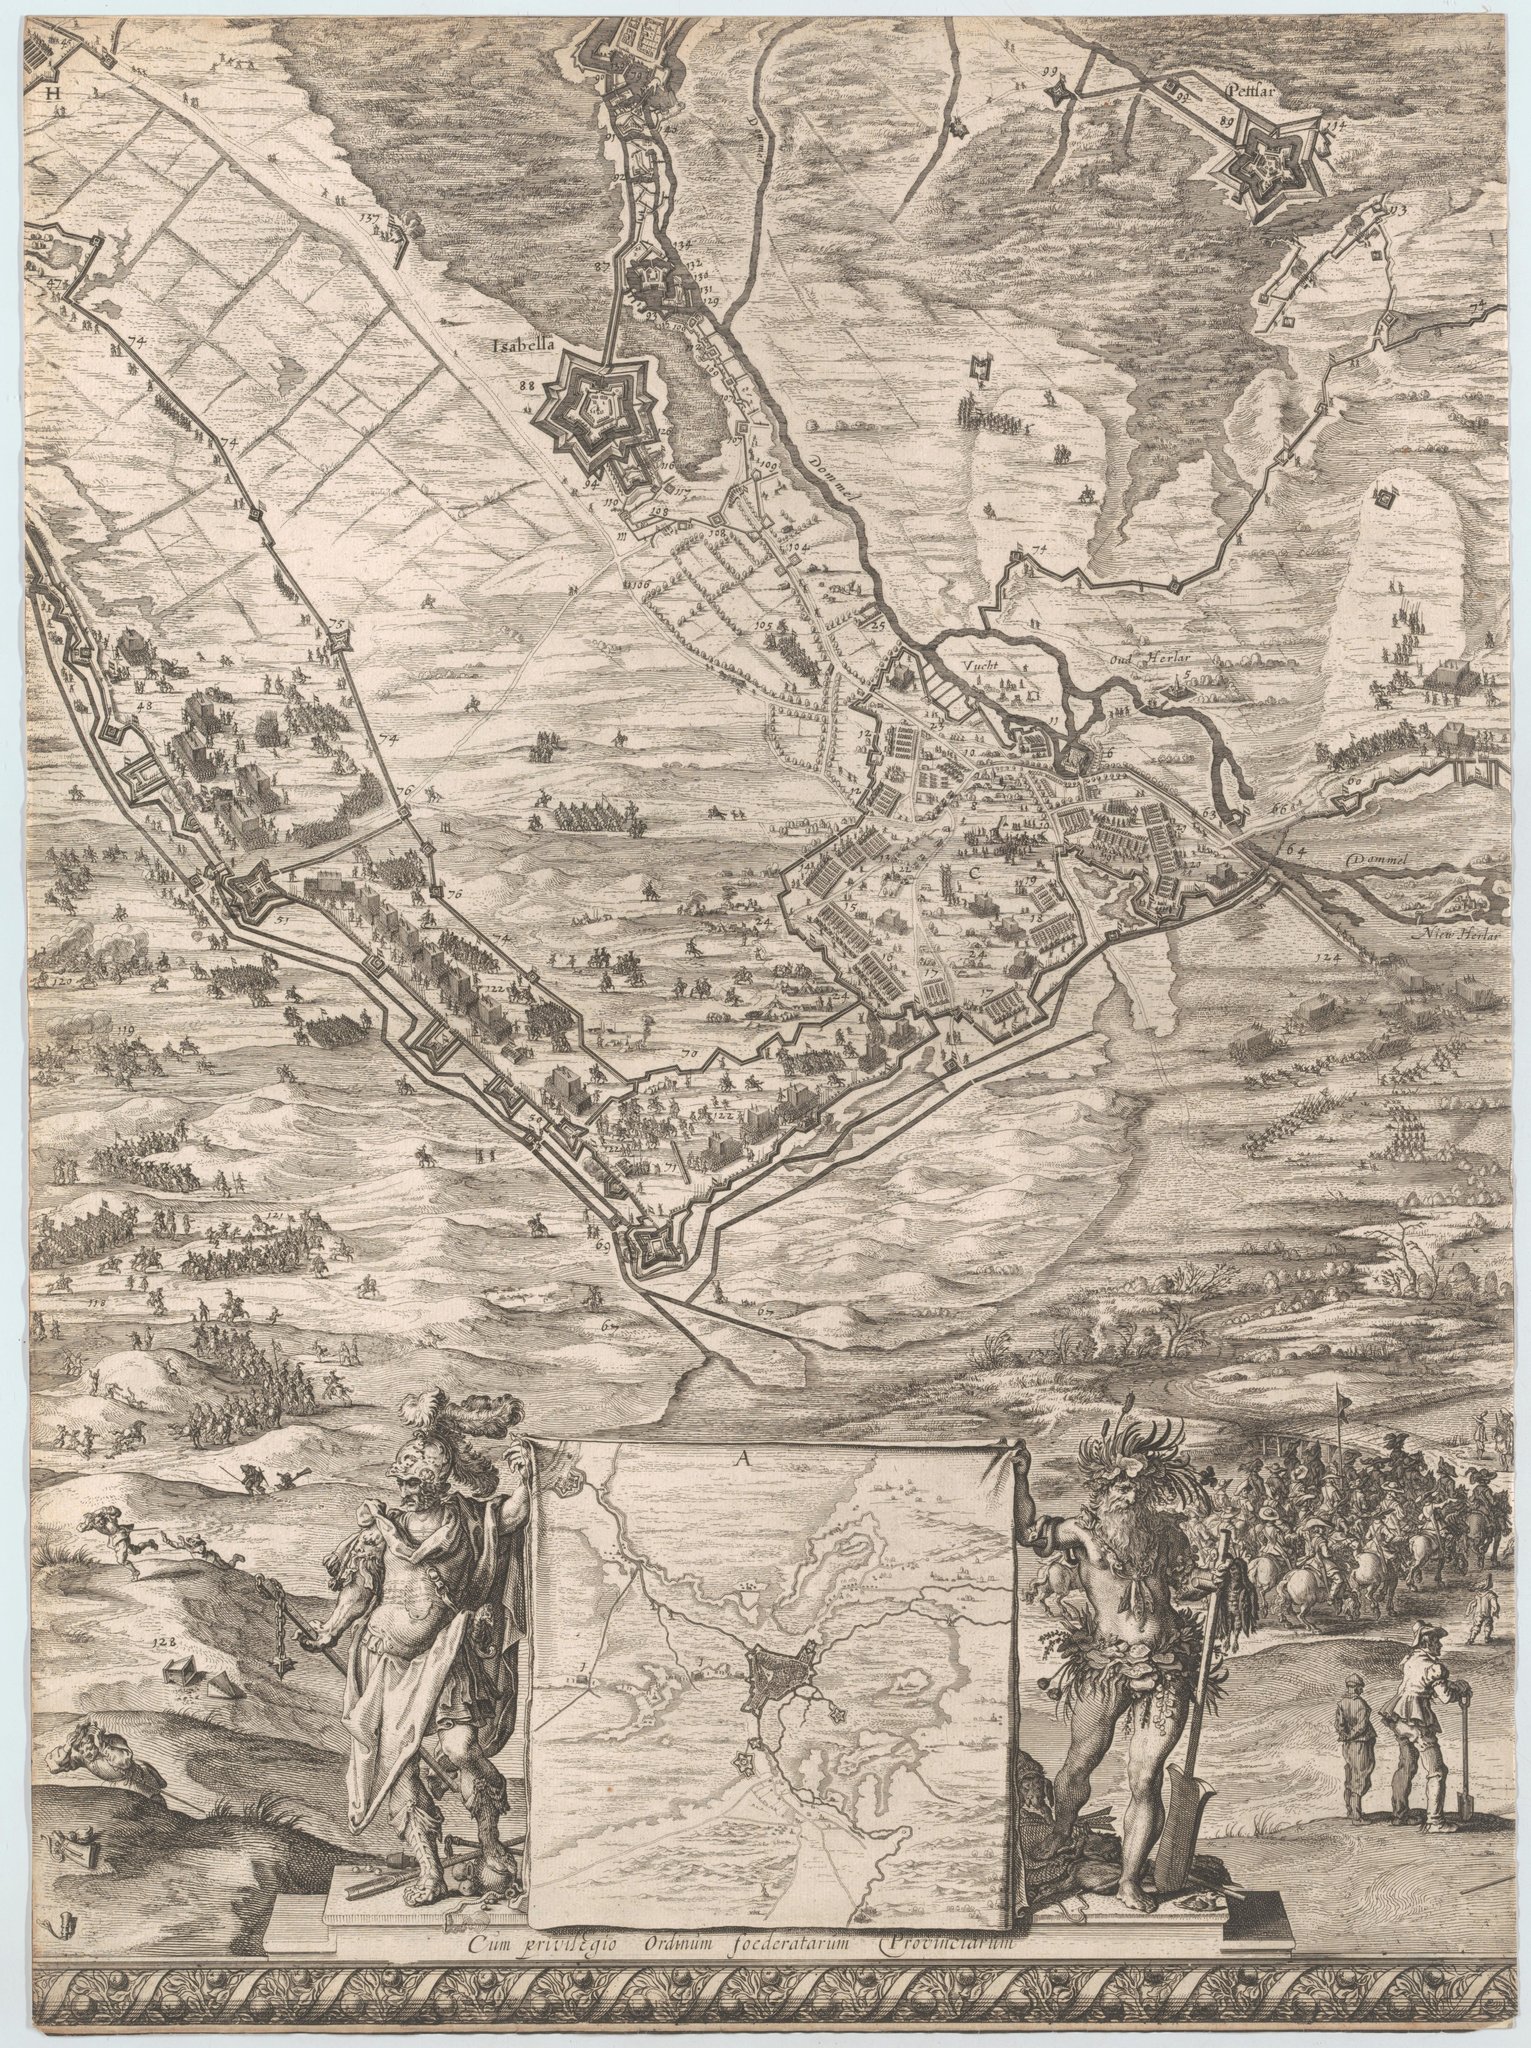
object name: print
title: Expugnatio Sylvae-Ducis Ao 1629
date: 1629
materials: paper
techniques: etching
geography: northern netherlands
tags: delft, frederick henry (prince of orange), maps of separate countries or regions, siege, position war, den bosch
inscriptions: collector's mark: Lugt 1641, stamp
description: Grote kaart van het beleg van Den Bosch door het Staatse leger onder Frederik Hendrik, van 1 mei tot 17 september 1629. Aan weerszijden van de kaart 18 kleine voorstellingen met details van de versterkingen van de stad en omliggende forten gemerkt I-Z. Kaart samengesteld uit zes platen en twee - ontbrekende - tekstbladen. Dit is het blad middenonder met een deel van de kaart met de omsingeling en het legerkamp bij Vught. Op de voorgrond twee allegorische figuren (Mars en een riviergod) die een kaart van het groter gebied ophouden. Onderwerpsrubrieken binnen de Atlas Zeden en Gewoonten: Krijgswezen, Verdedigingswerken.